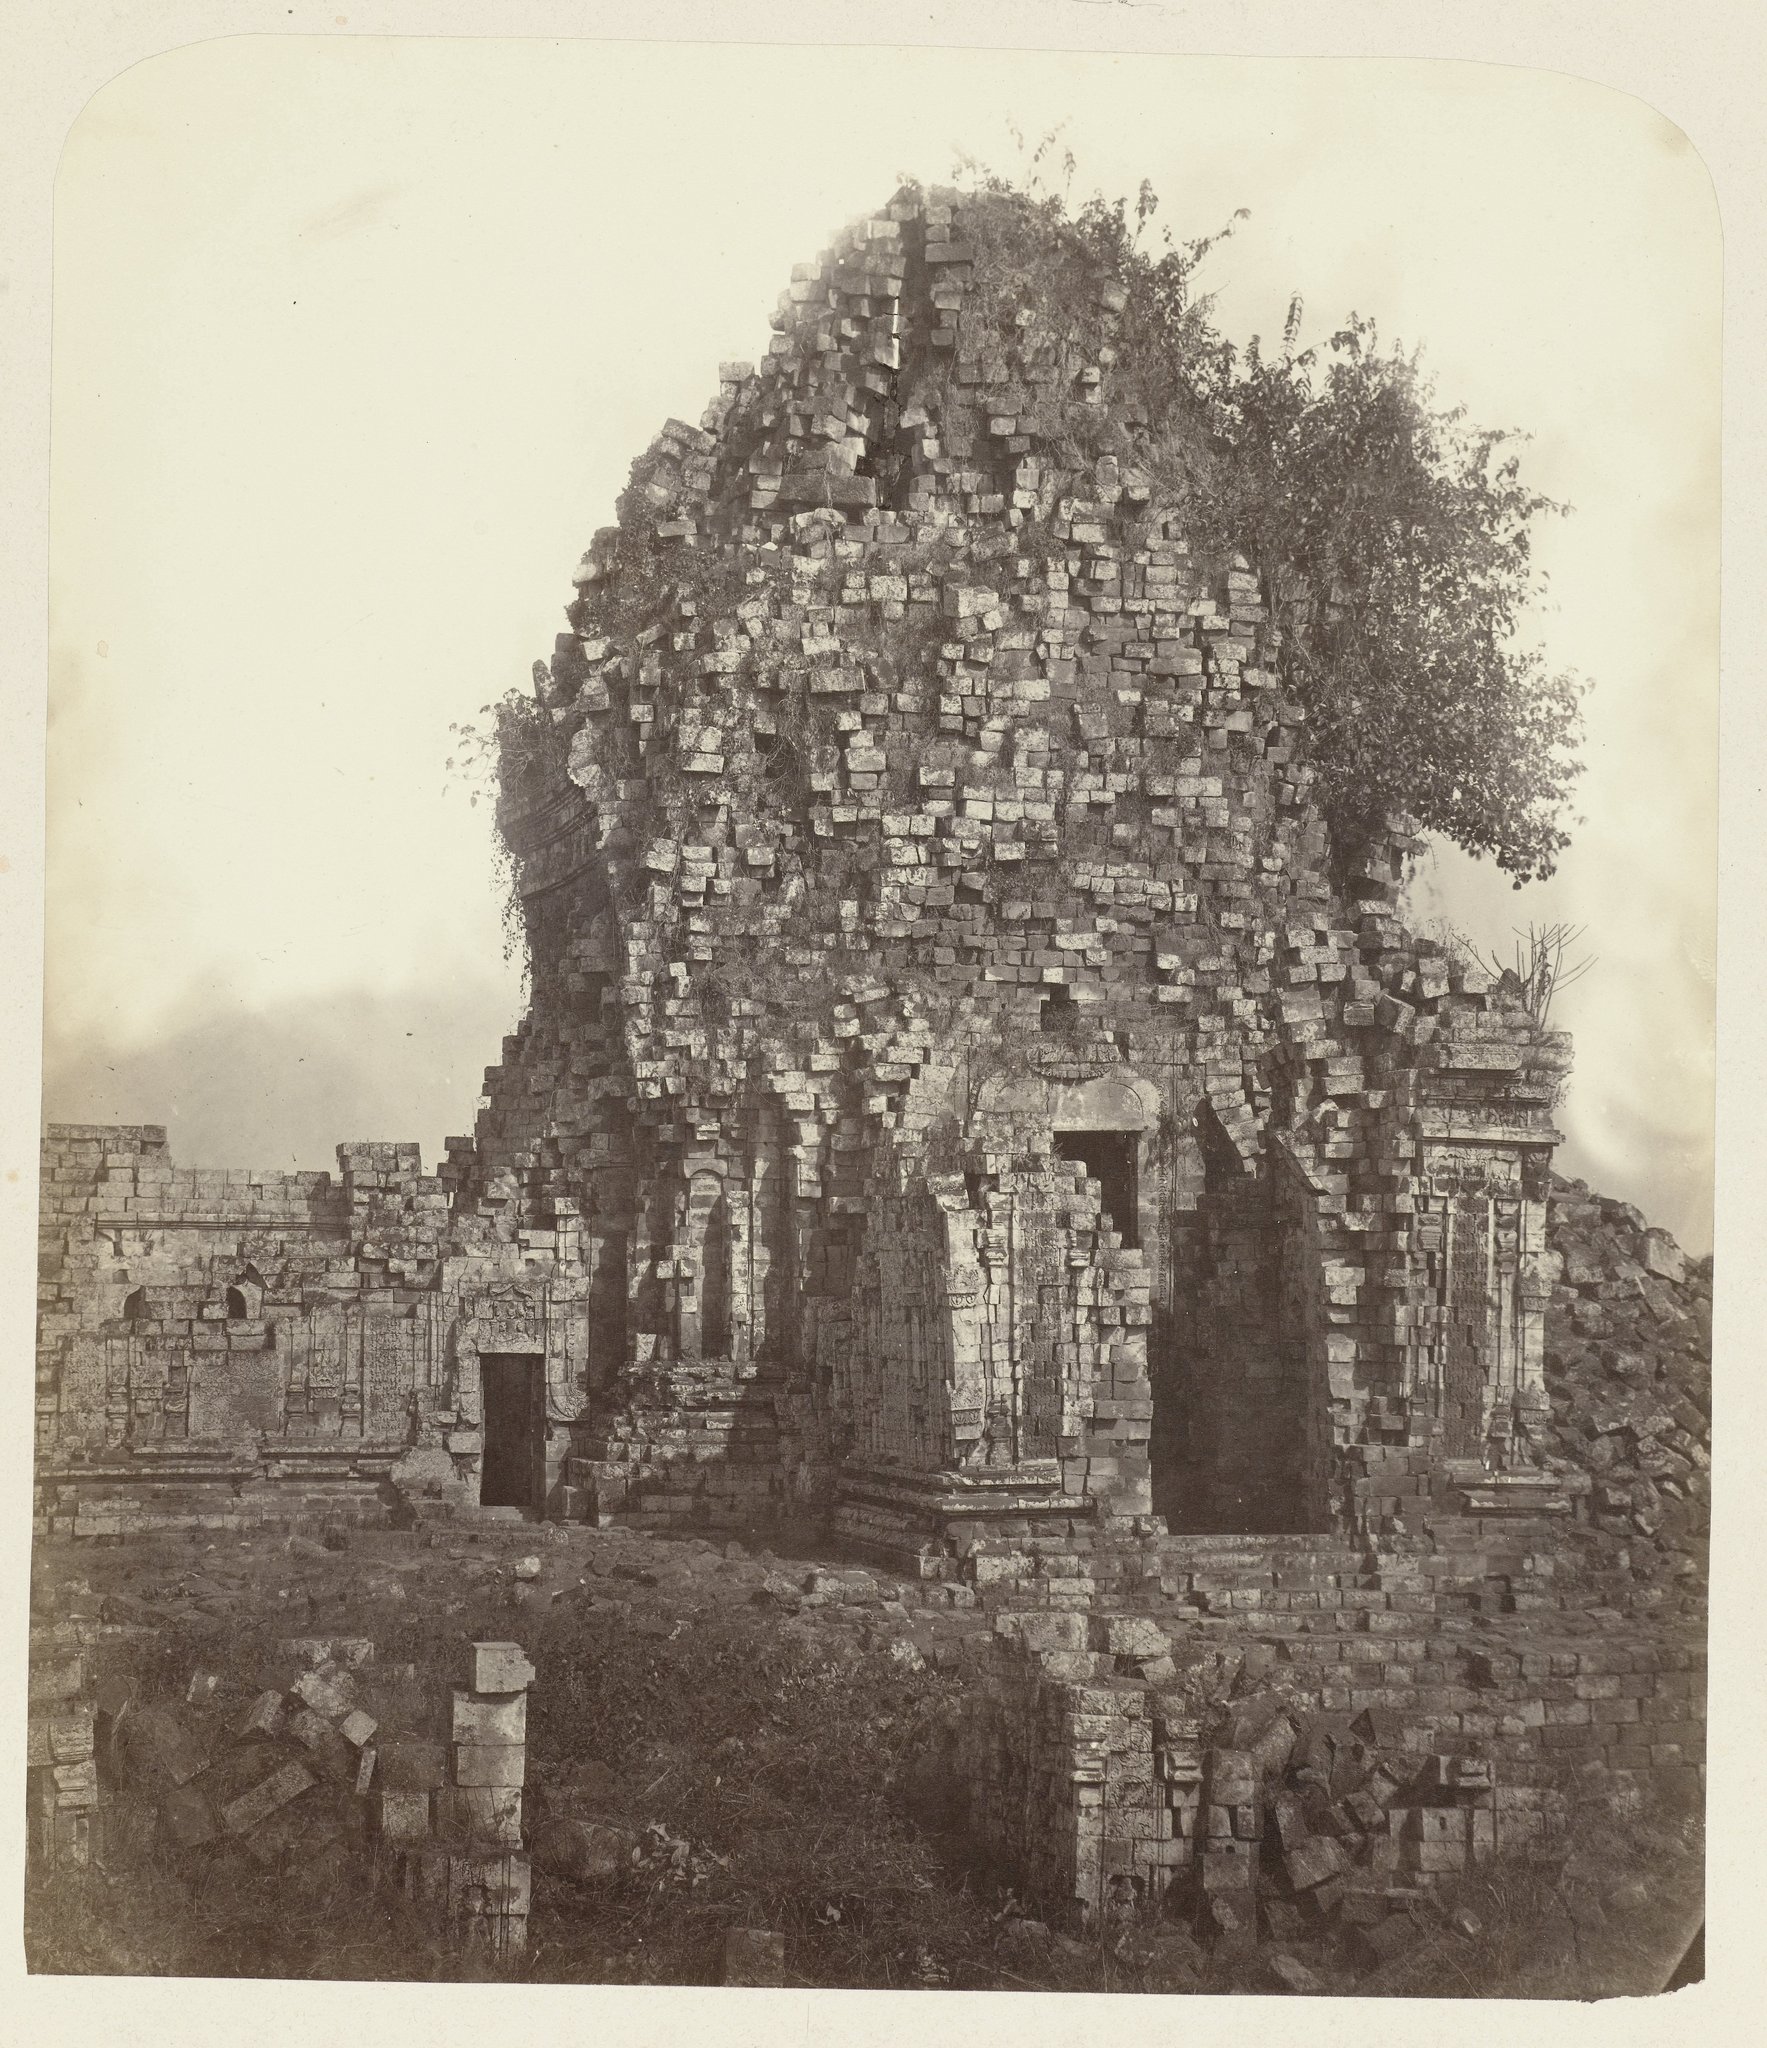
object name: photograph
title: Candi Sewu (Temple complex)(Buddhist) main temple. Bokoharjo, Yogyakarta district, D.I. Yogyakarta province, 8th -9th century.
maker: isidore kinsbergen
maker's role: fotograaf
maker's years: 1821-1905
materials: cardboard, paper, photographic support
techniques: albumen print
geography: java